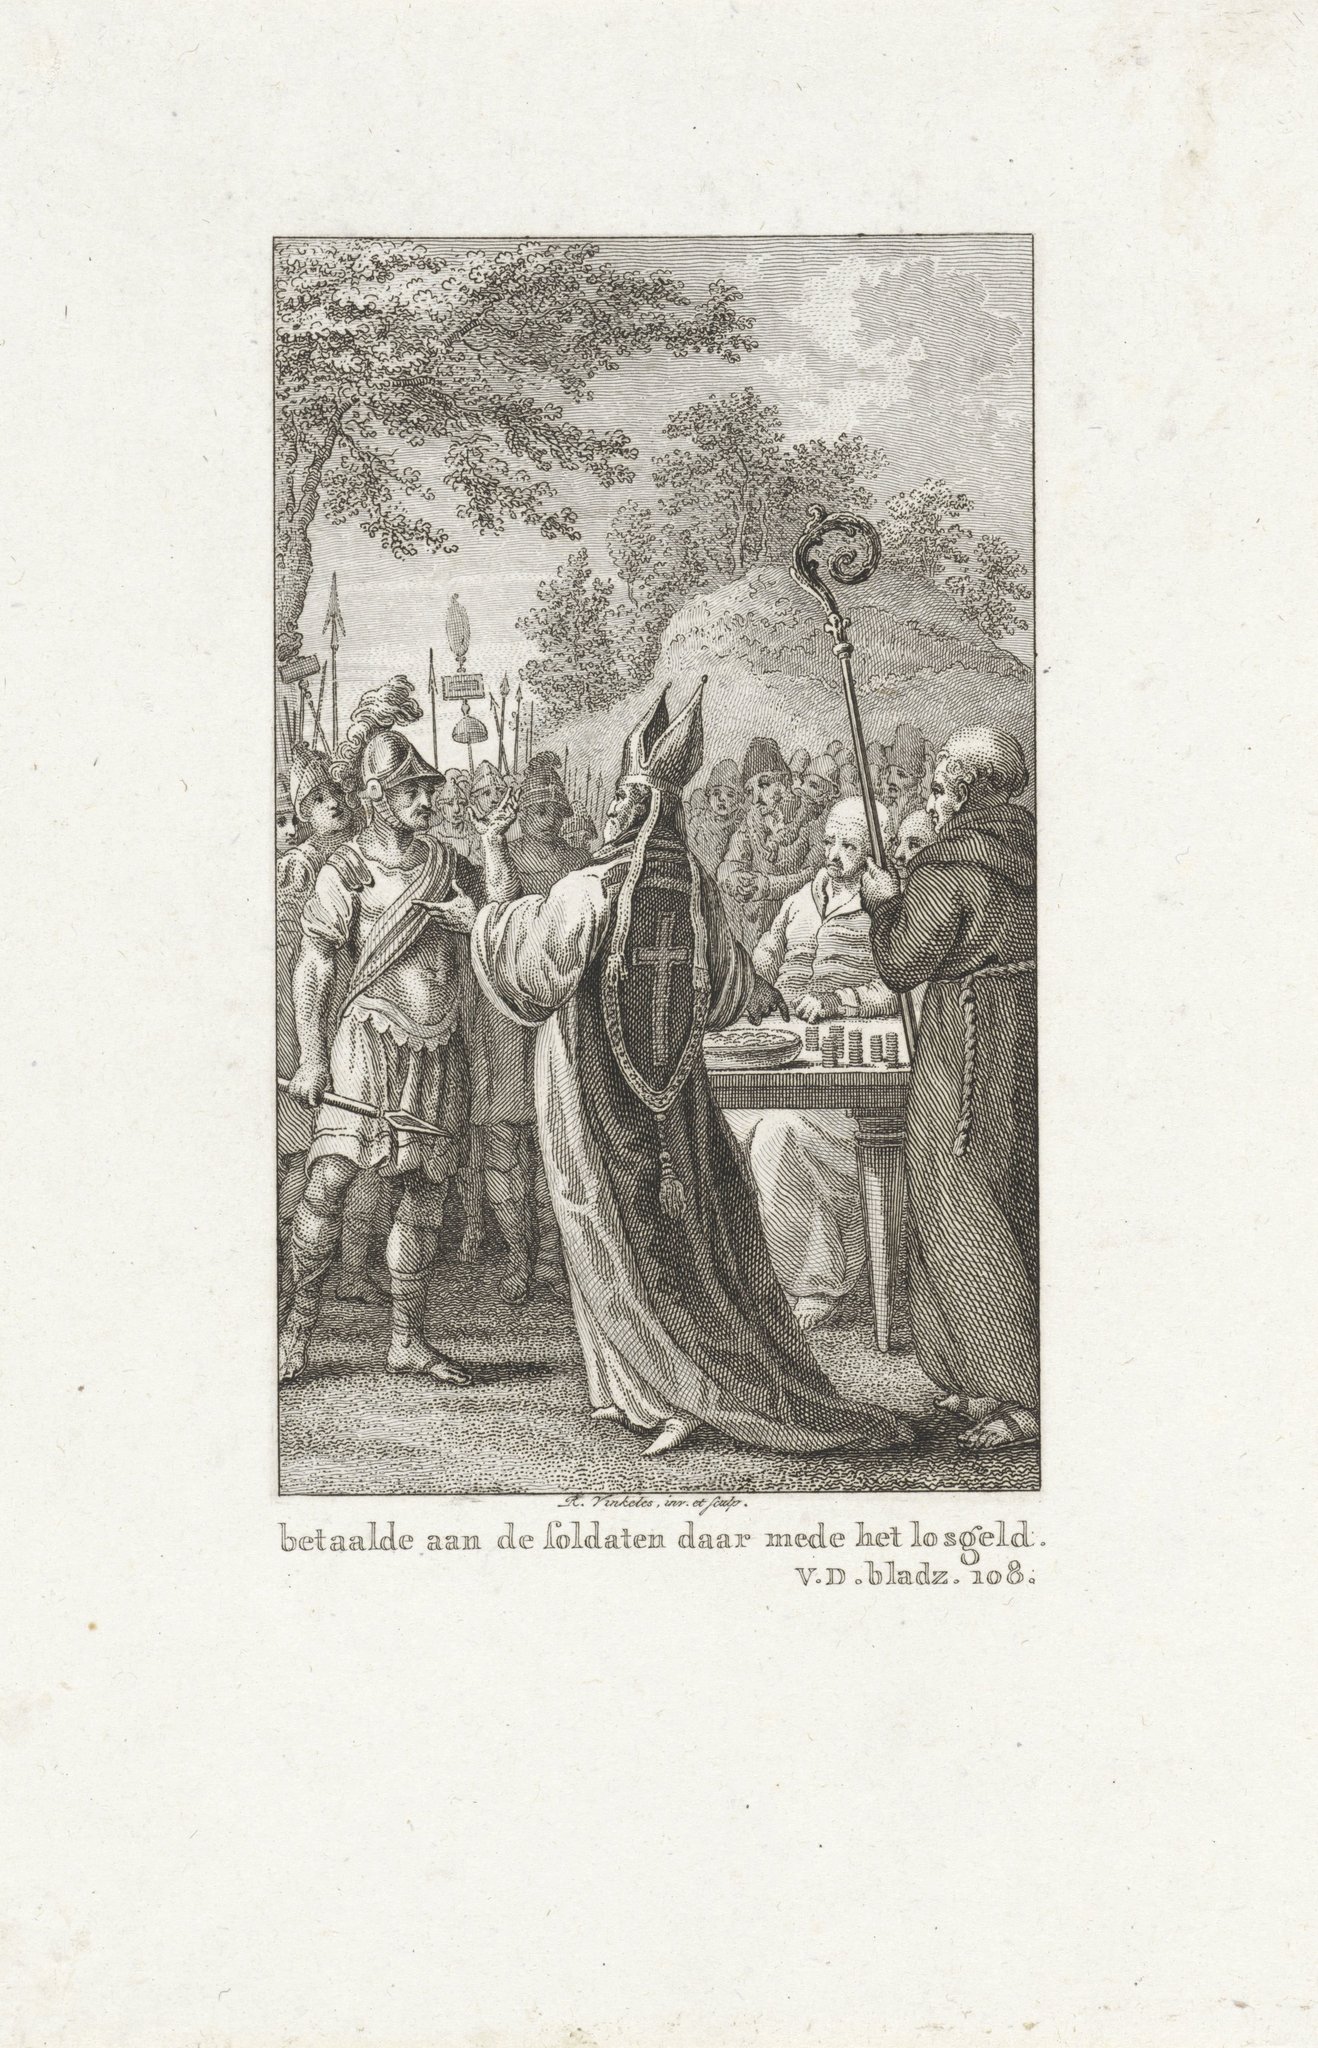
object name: book illustration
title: Acacius van Amida betaalt losgeld aan de Romeinen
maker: reinier vinkeles (i)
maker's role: draughtsman, print maker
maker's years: 1741-1816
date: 1802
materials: paper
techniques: engraving, etching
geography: amsterdam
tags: archbishop, bishop, etc. (roman catholic), the soldier; the soldier's life, freeing a prisoner; ransoming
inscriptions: collector's mark: Lugt 240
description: Acacius, bisschop van Amida, betaalt losgeld aan de Romeinen om 7000 Persische gevangenen te bevrijden die anders verhongerd waren. De bisschop bracht het geld bijeen door kerkelijke kannen, schalen en bekers van goud en zilver om te laten smelten.